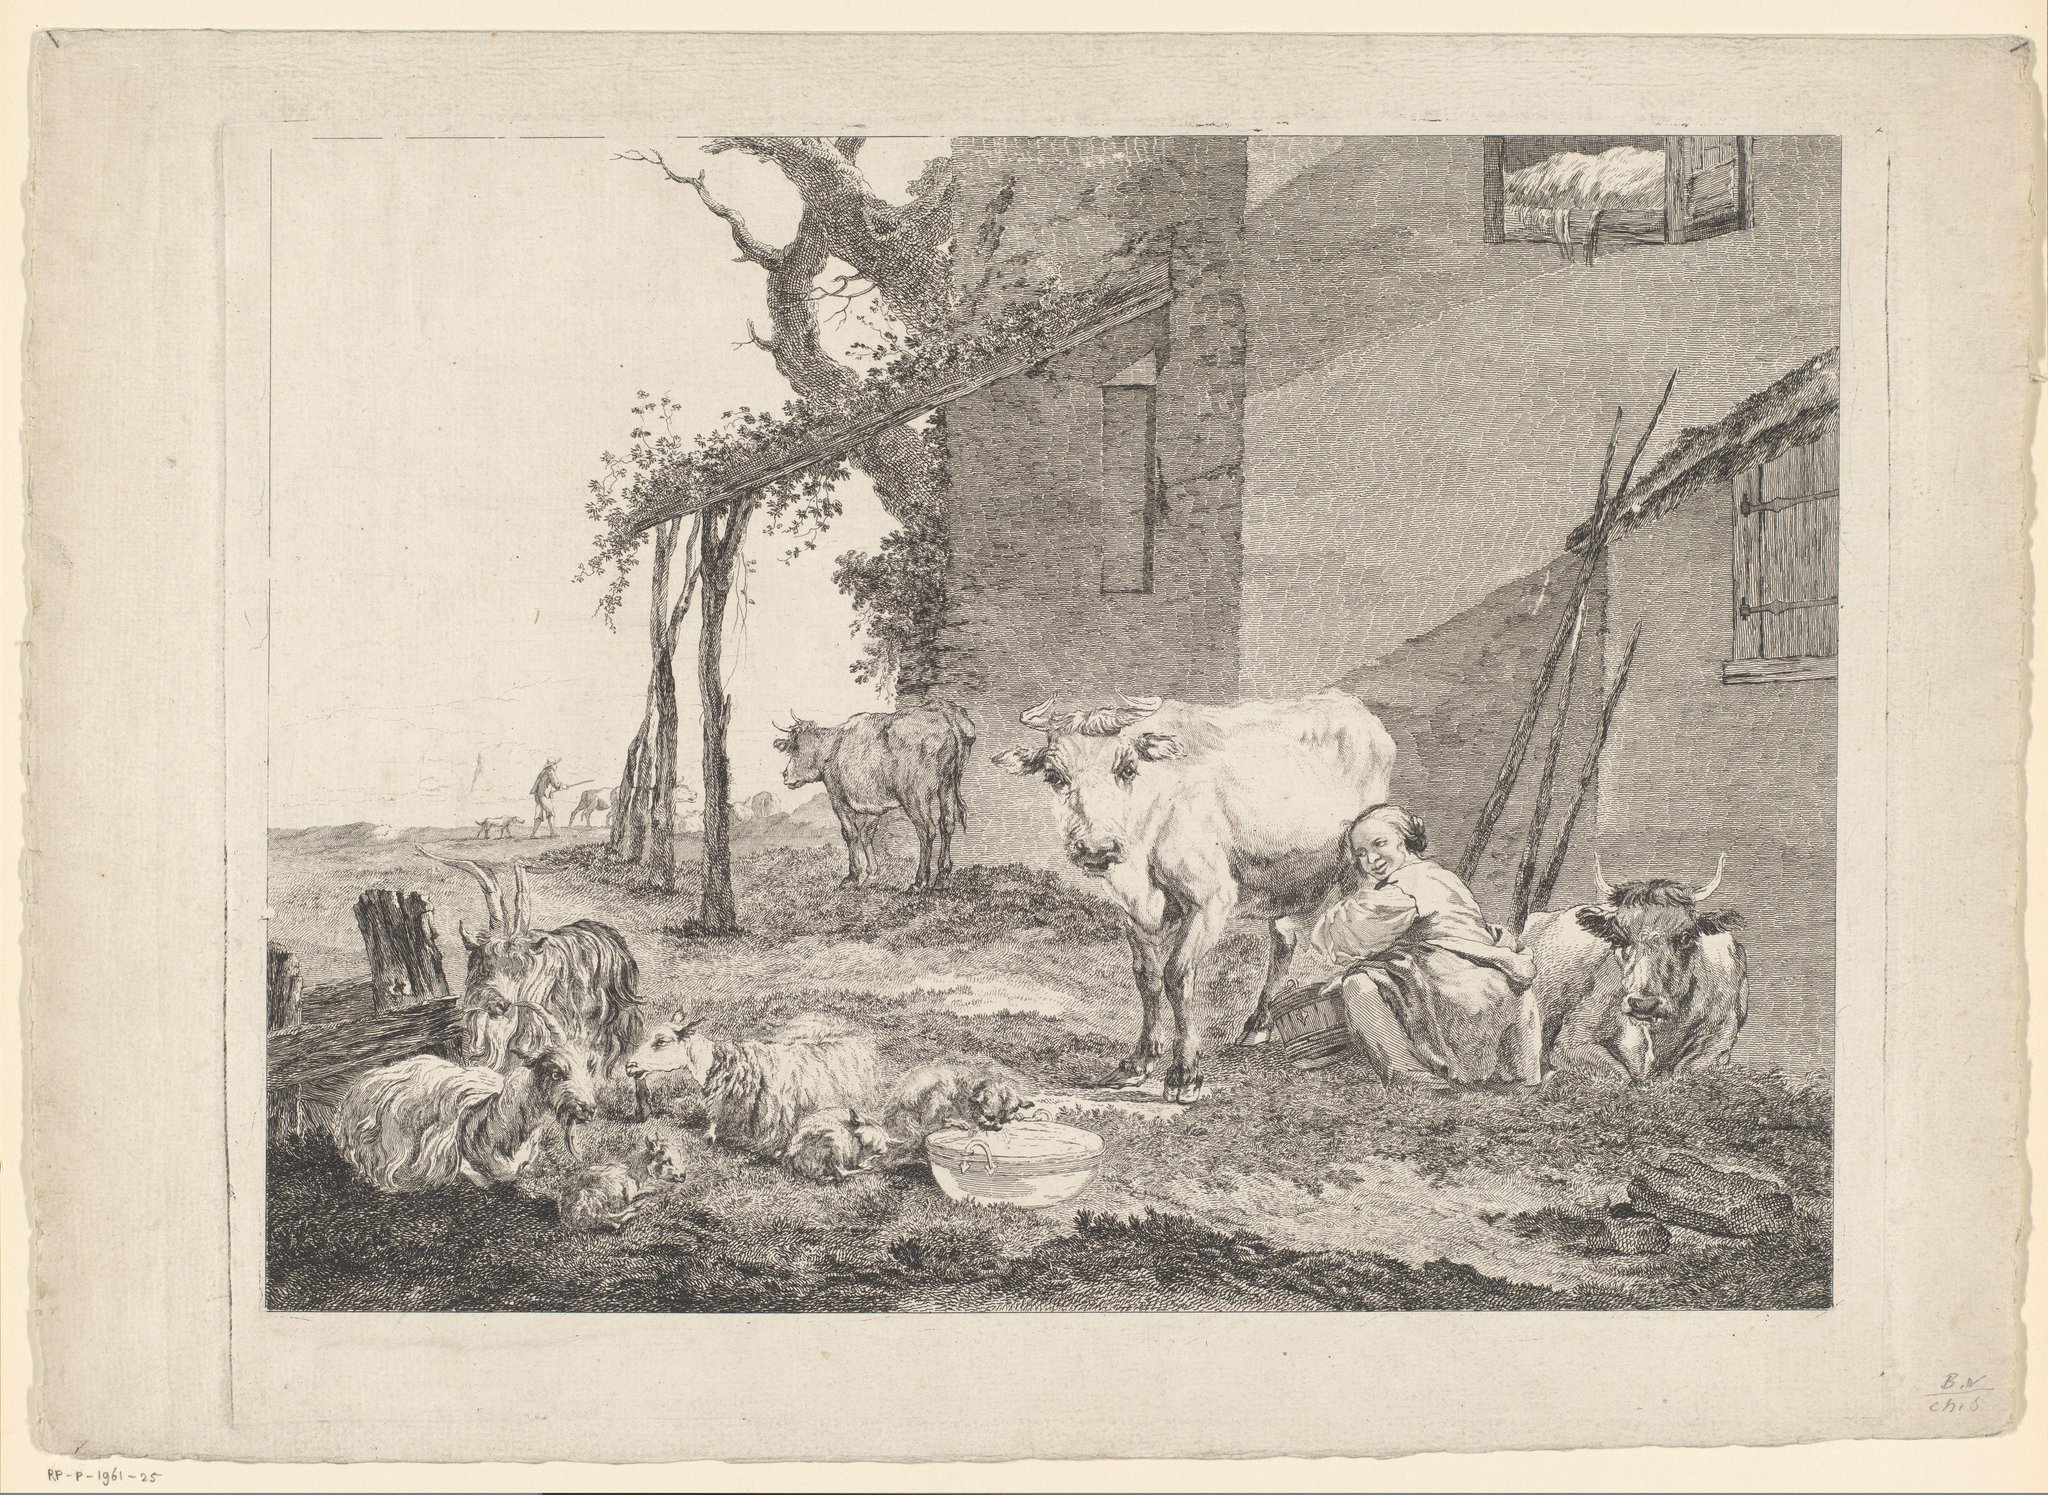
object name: print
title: Melkende herderin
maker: pierre françois laurent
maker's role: print maker, printer, publisher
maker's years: 1739-1809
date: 1773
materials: paper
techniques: etching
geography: france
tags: herding, herdsman, herdswoman, shepherd, shepherdess, cowherd, etc., milkmaid, farm or solitary house in landscape, milking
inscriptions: collector's mark: Lugt 2760, collector's mark: Lugt 2228